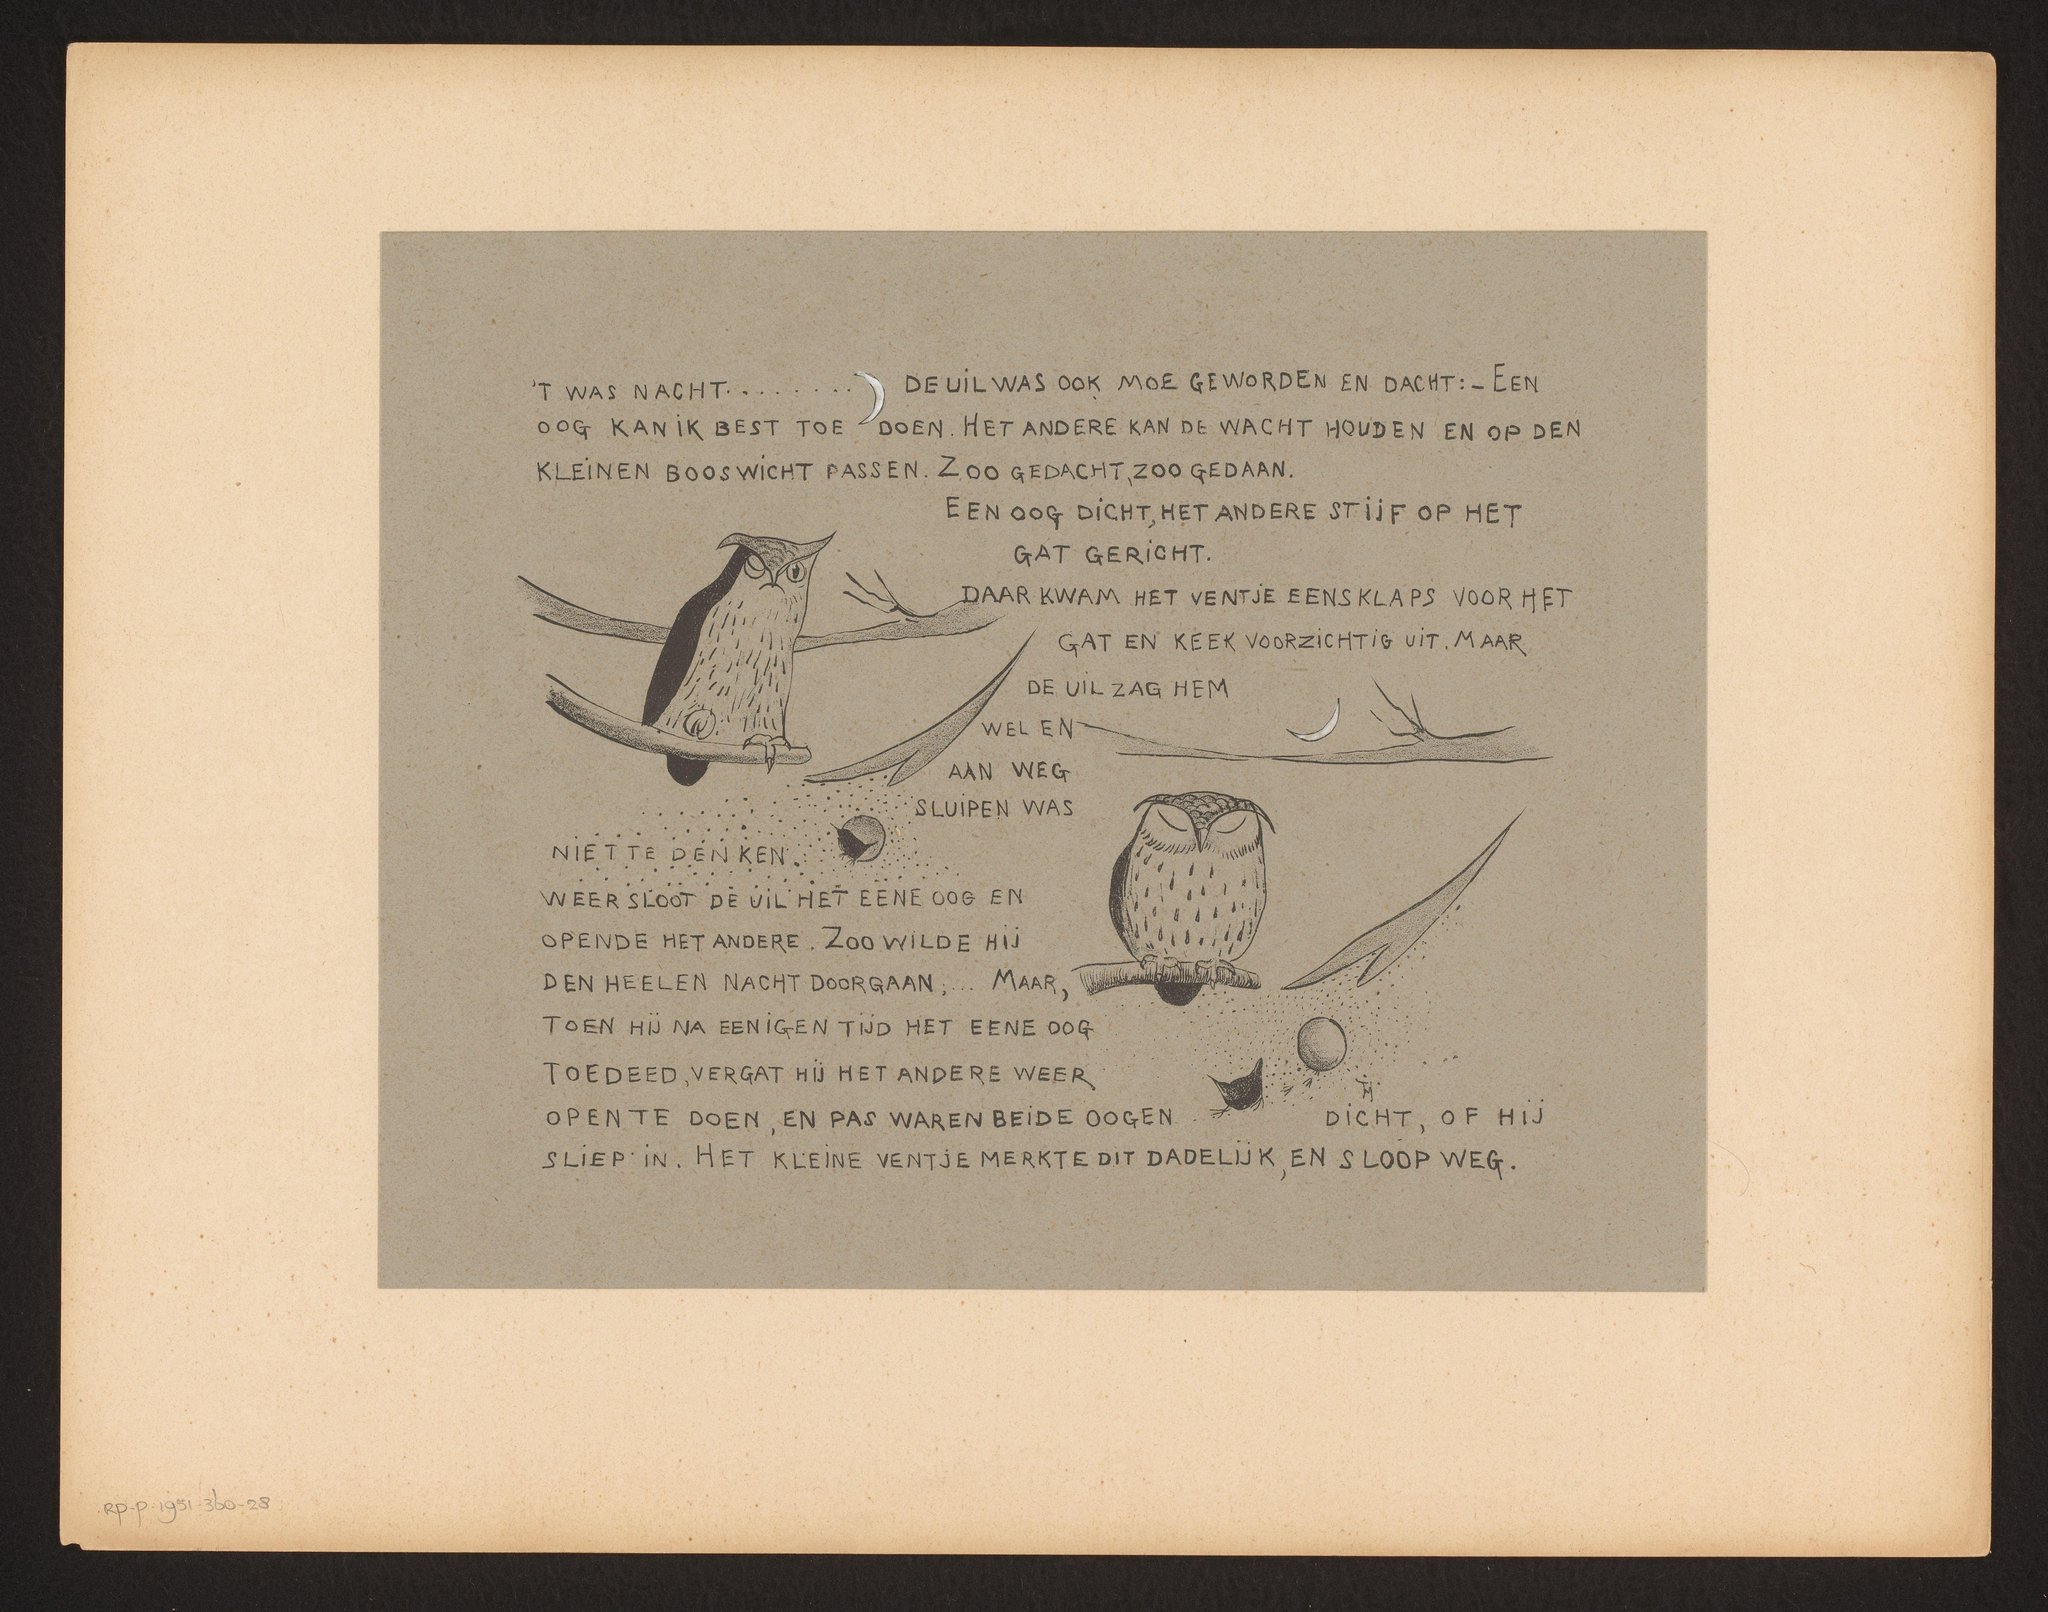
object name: print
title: Hoe de vogels aan een koning kwamen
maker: theo van hoytema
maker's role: draughtsman, painter, print maker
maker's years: 1863-1917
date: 1892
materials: paper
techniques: hand coloring, lithograph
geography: the hague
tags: song-birds: wren, owls, moon as celestial body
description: Zowel tekst als afbeelding zijn gelithografeerd.